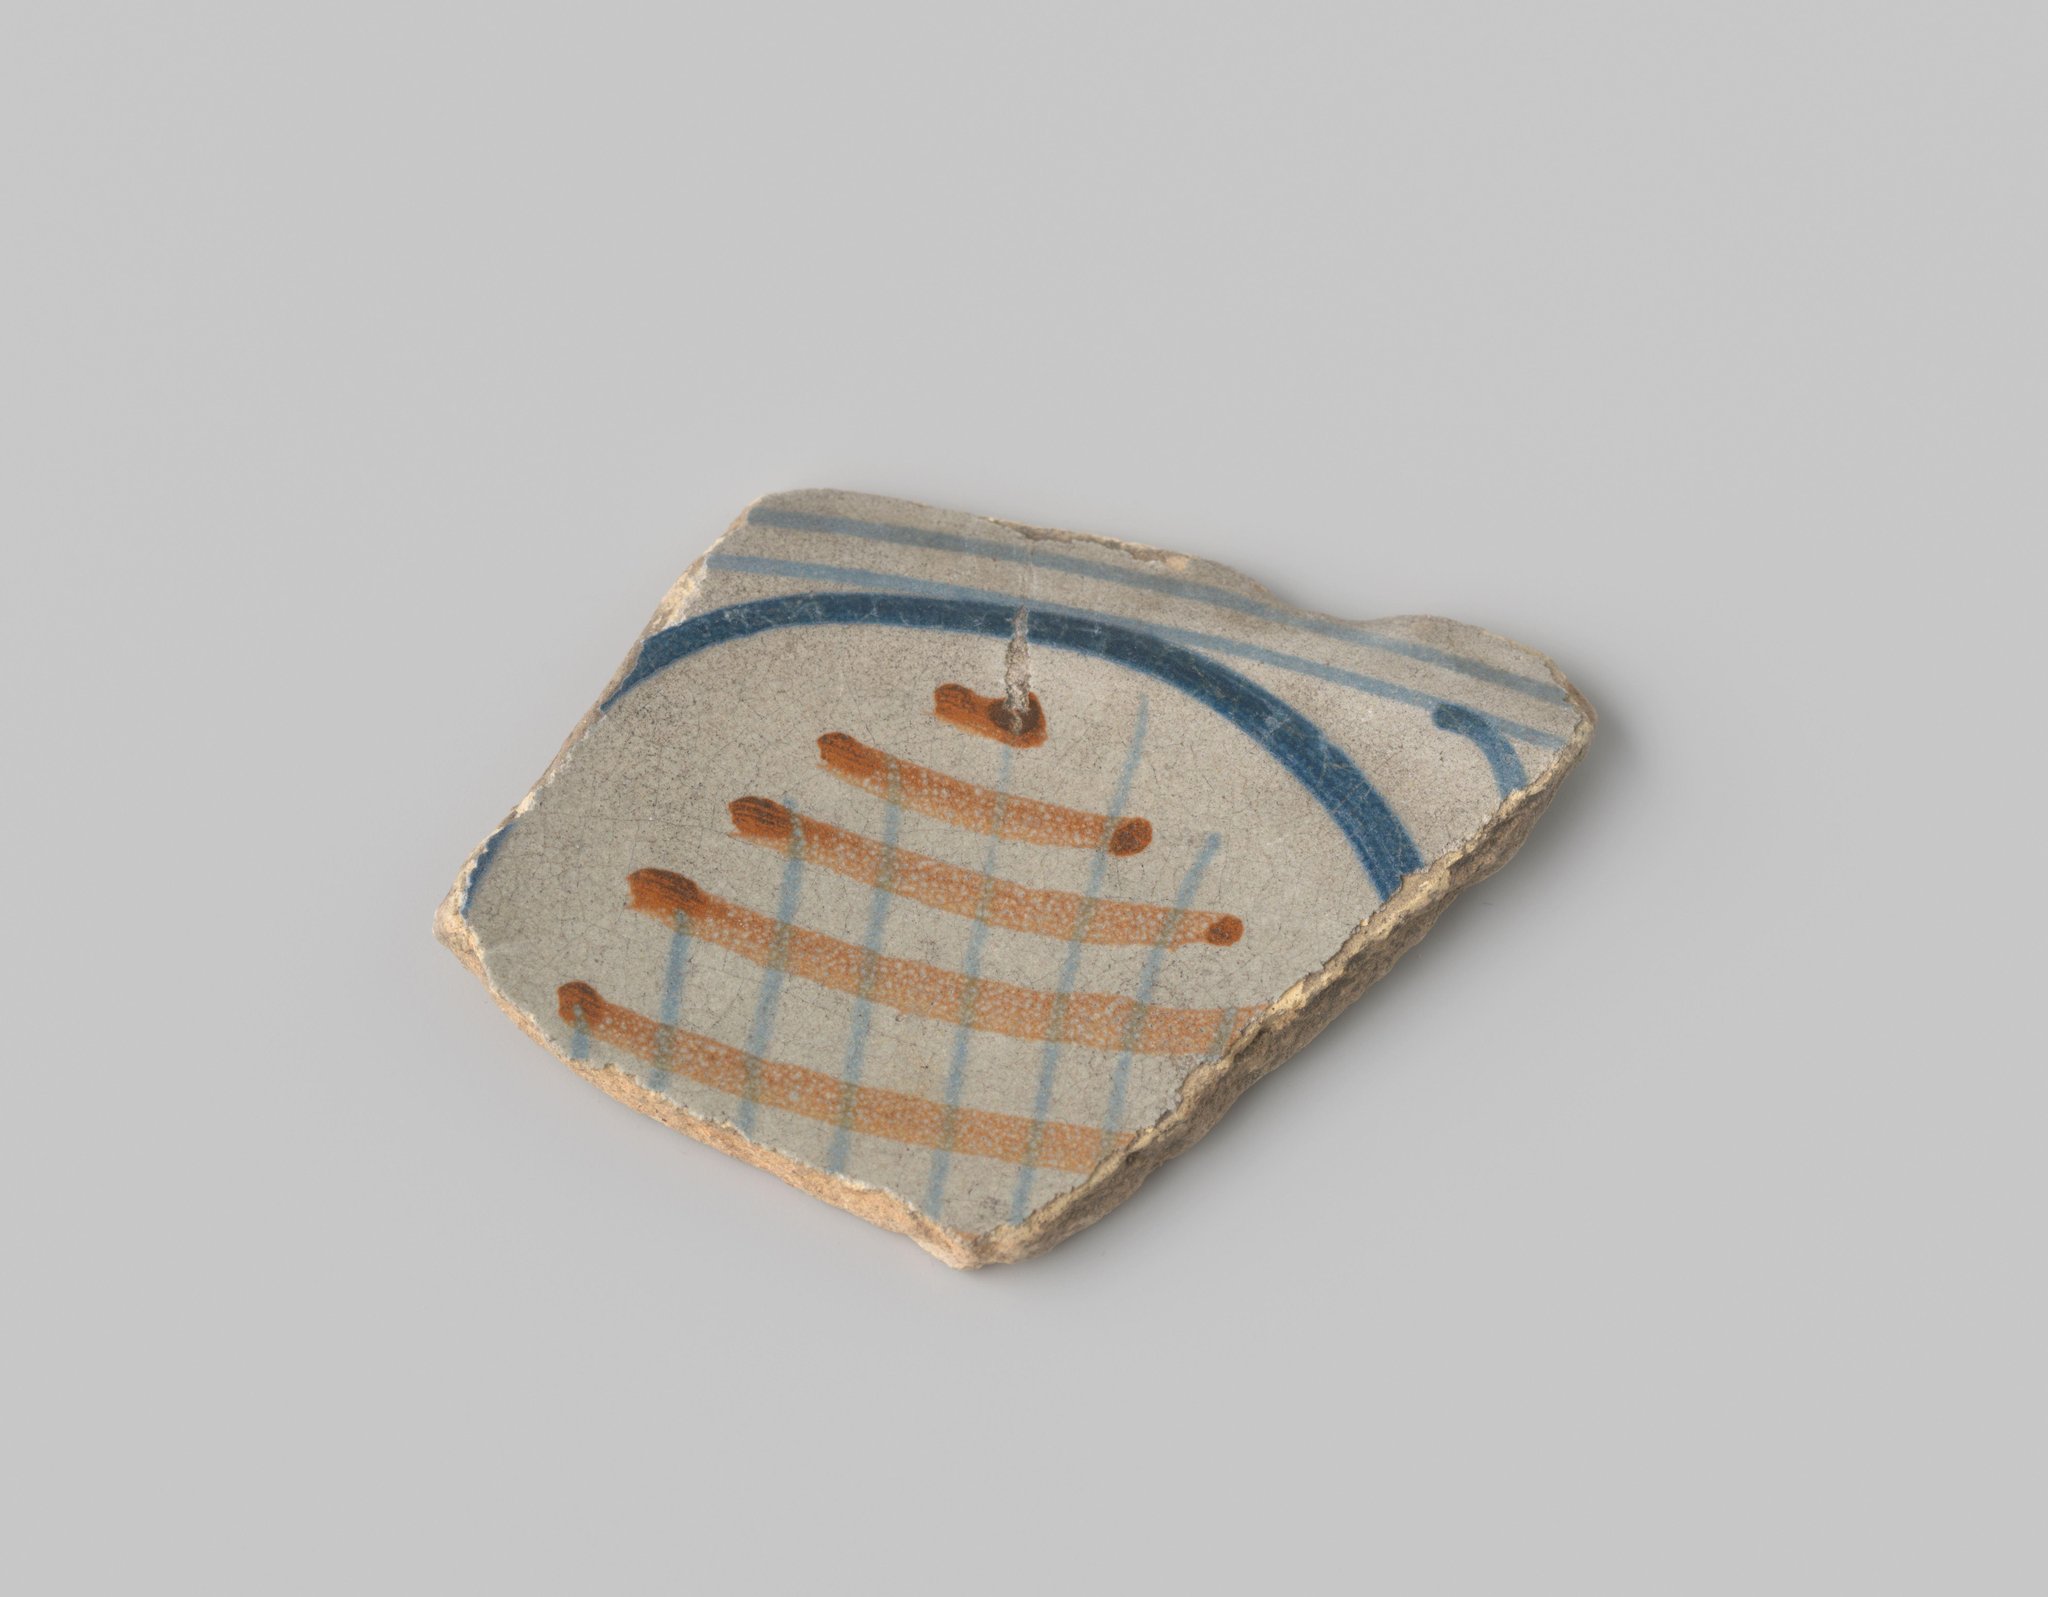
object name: sherd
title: Scherf veelkleurig majolica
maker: Anonymous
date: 1500-1699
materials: earthenware, glaze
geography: northern netherlands